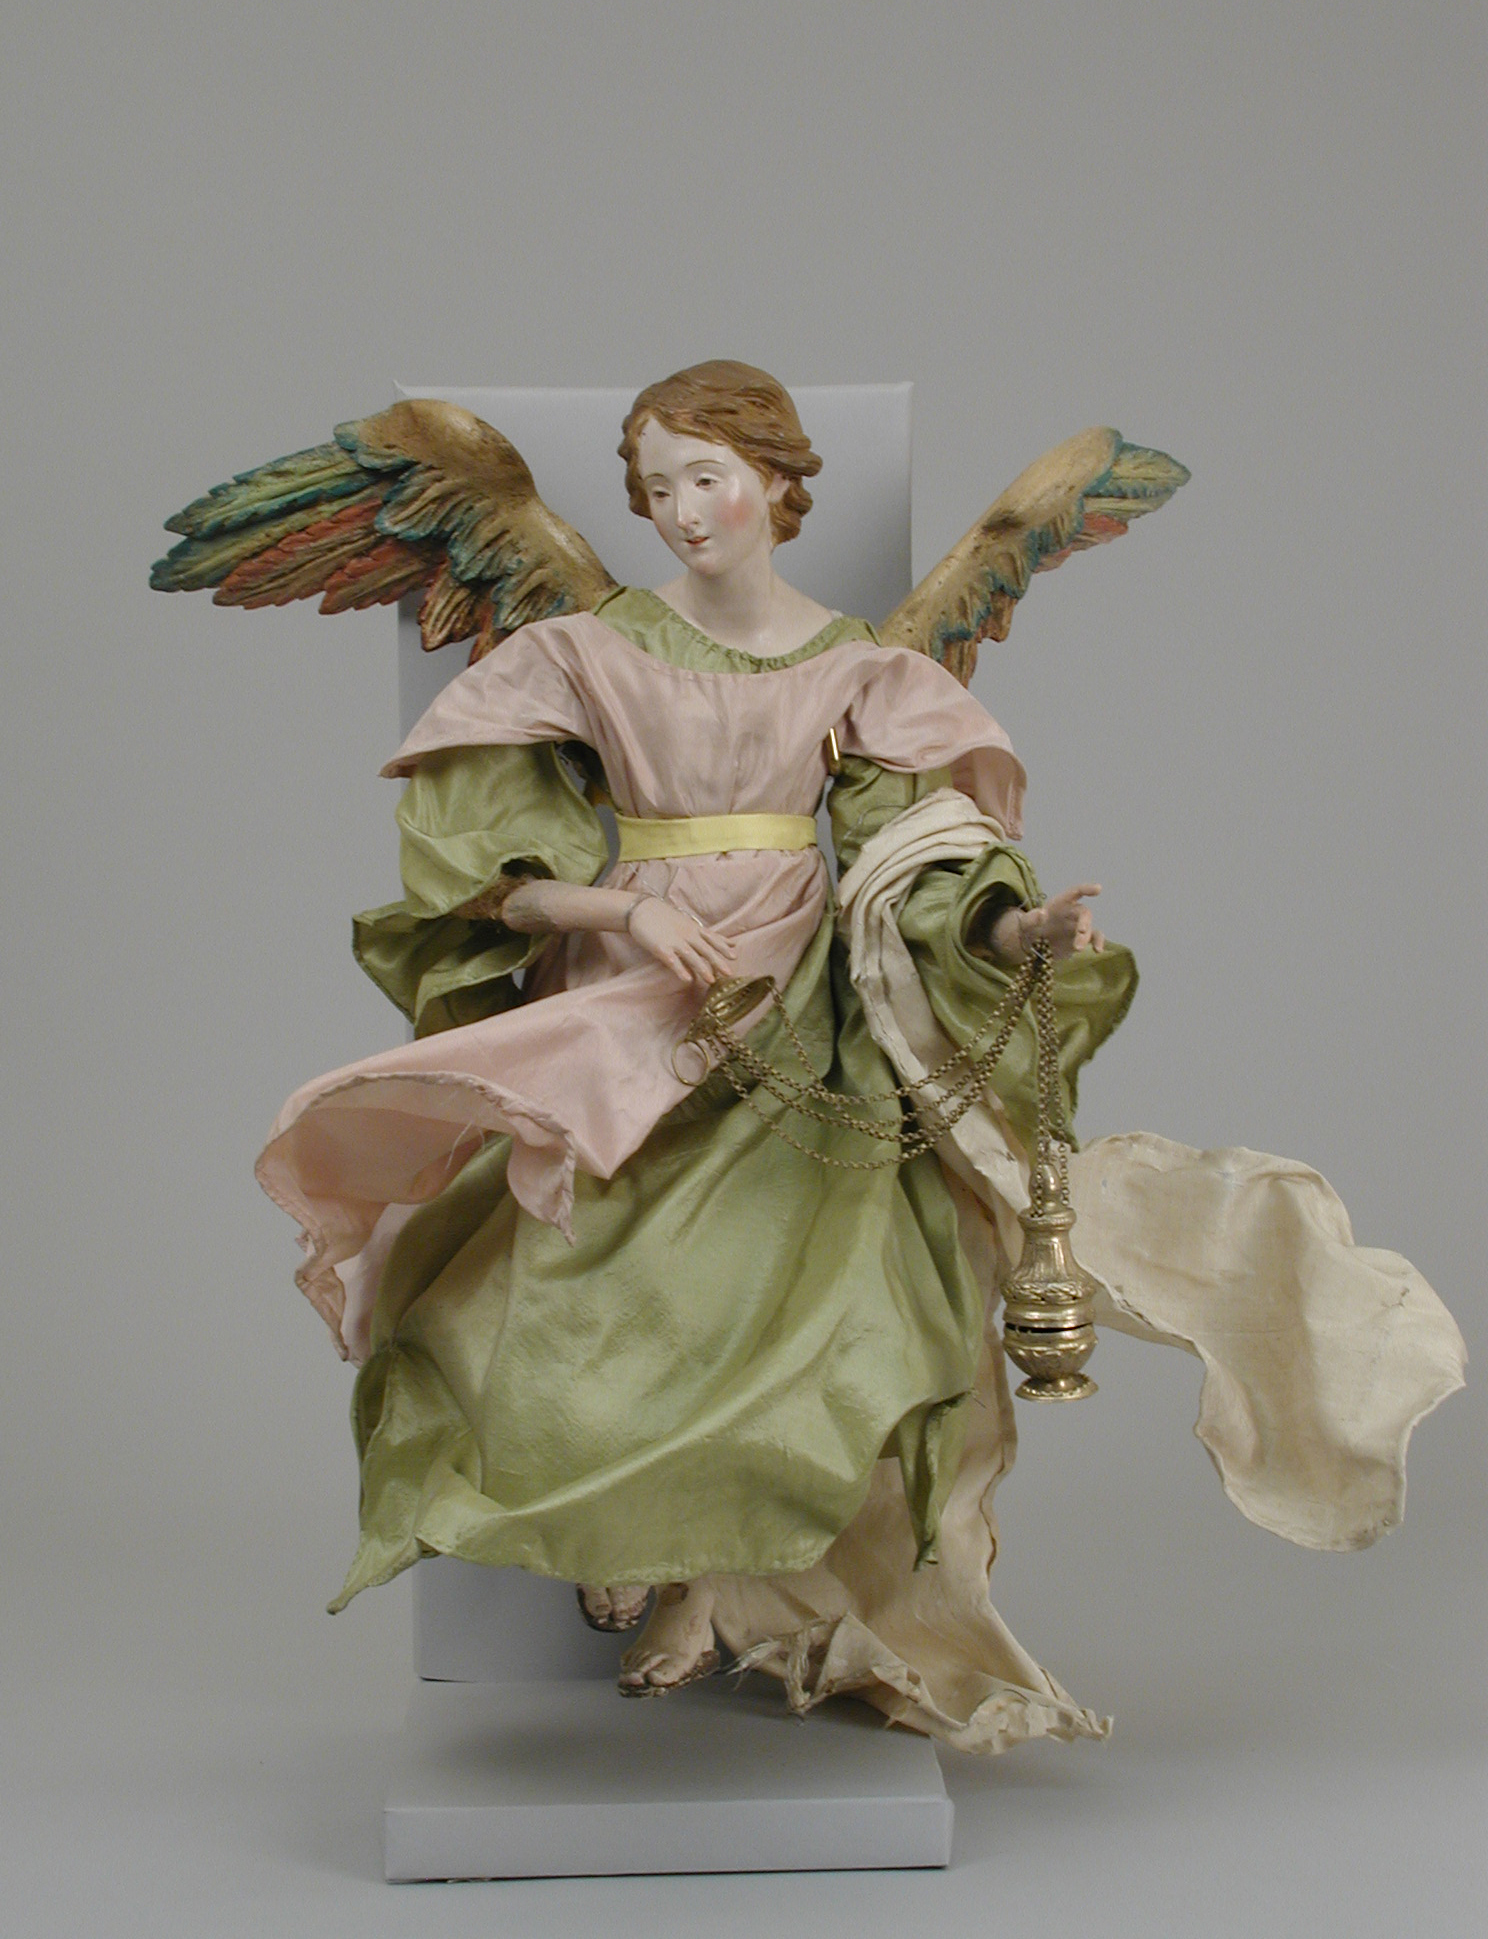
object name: crèche figure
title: Angel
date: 1751-1800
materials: terracotta, fiber, metal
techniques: polychrome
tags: angels,censers